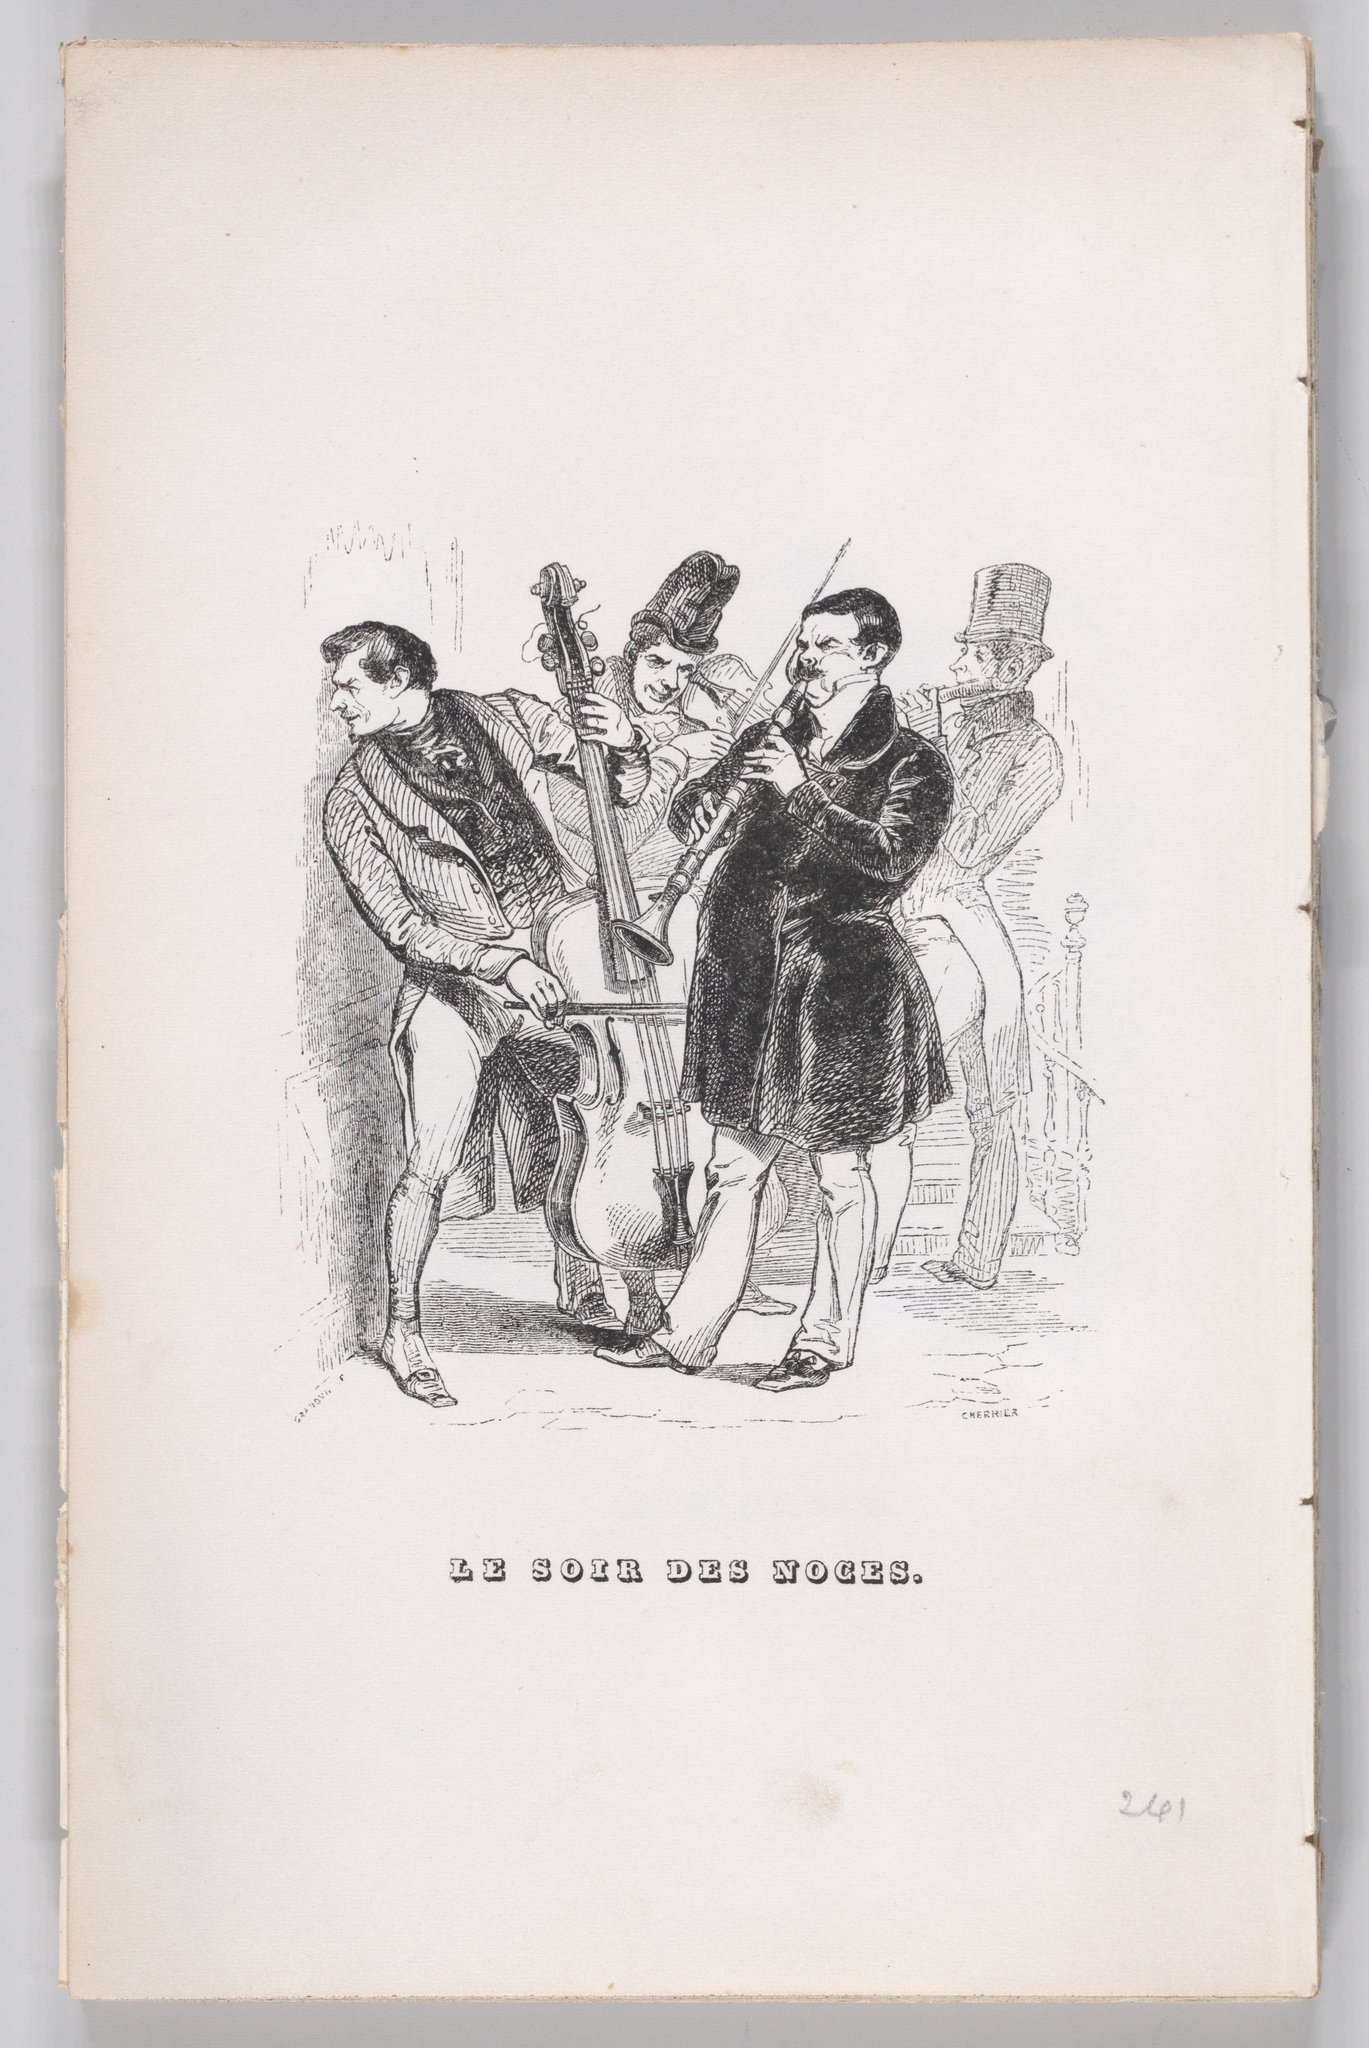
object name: print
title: The Wedding Night, from "The Complete Works of Béranger"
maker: j. j. grandville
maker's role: illustrator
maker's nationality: french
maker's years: 1803-1847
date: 1836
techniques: engraving